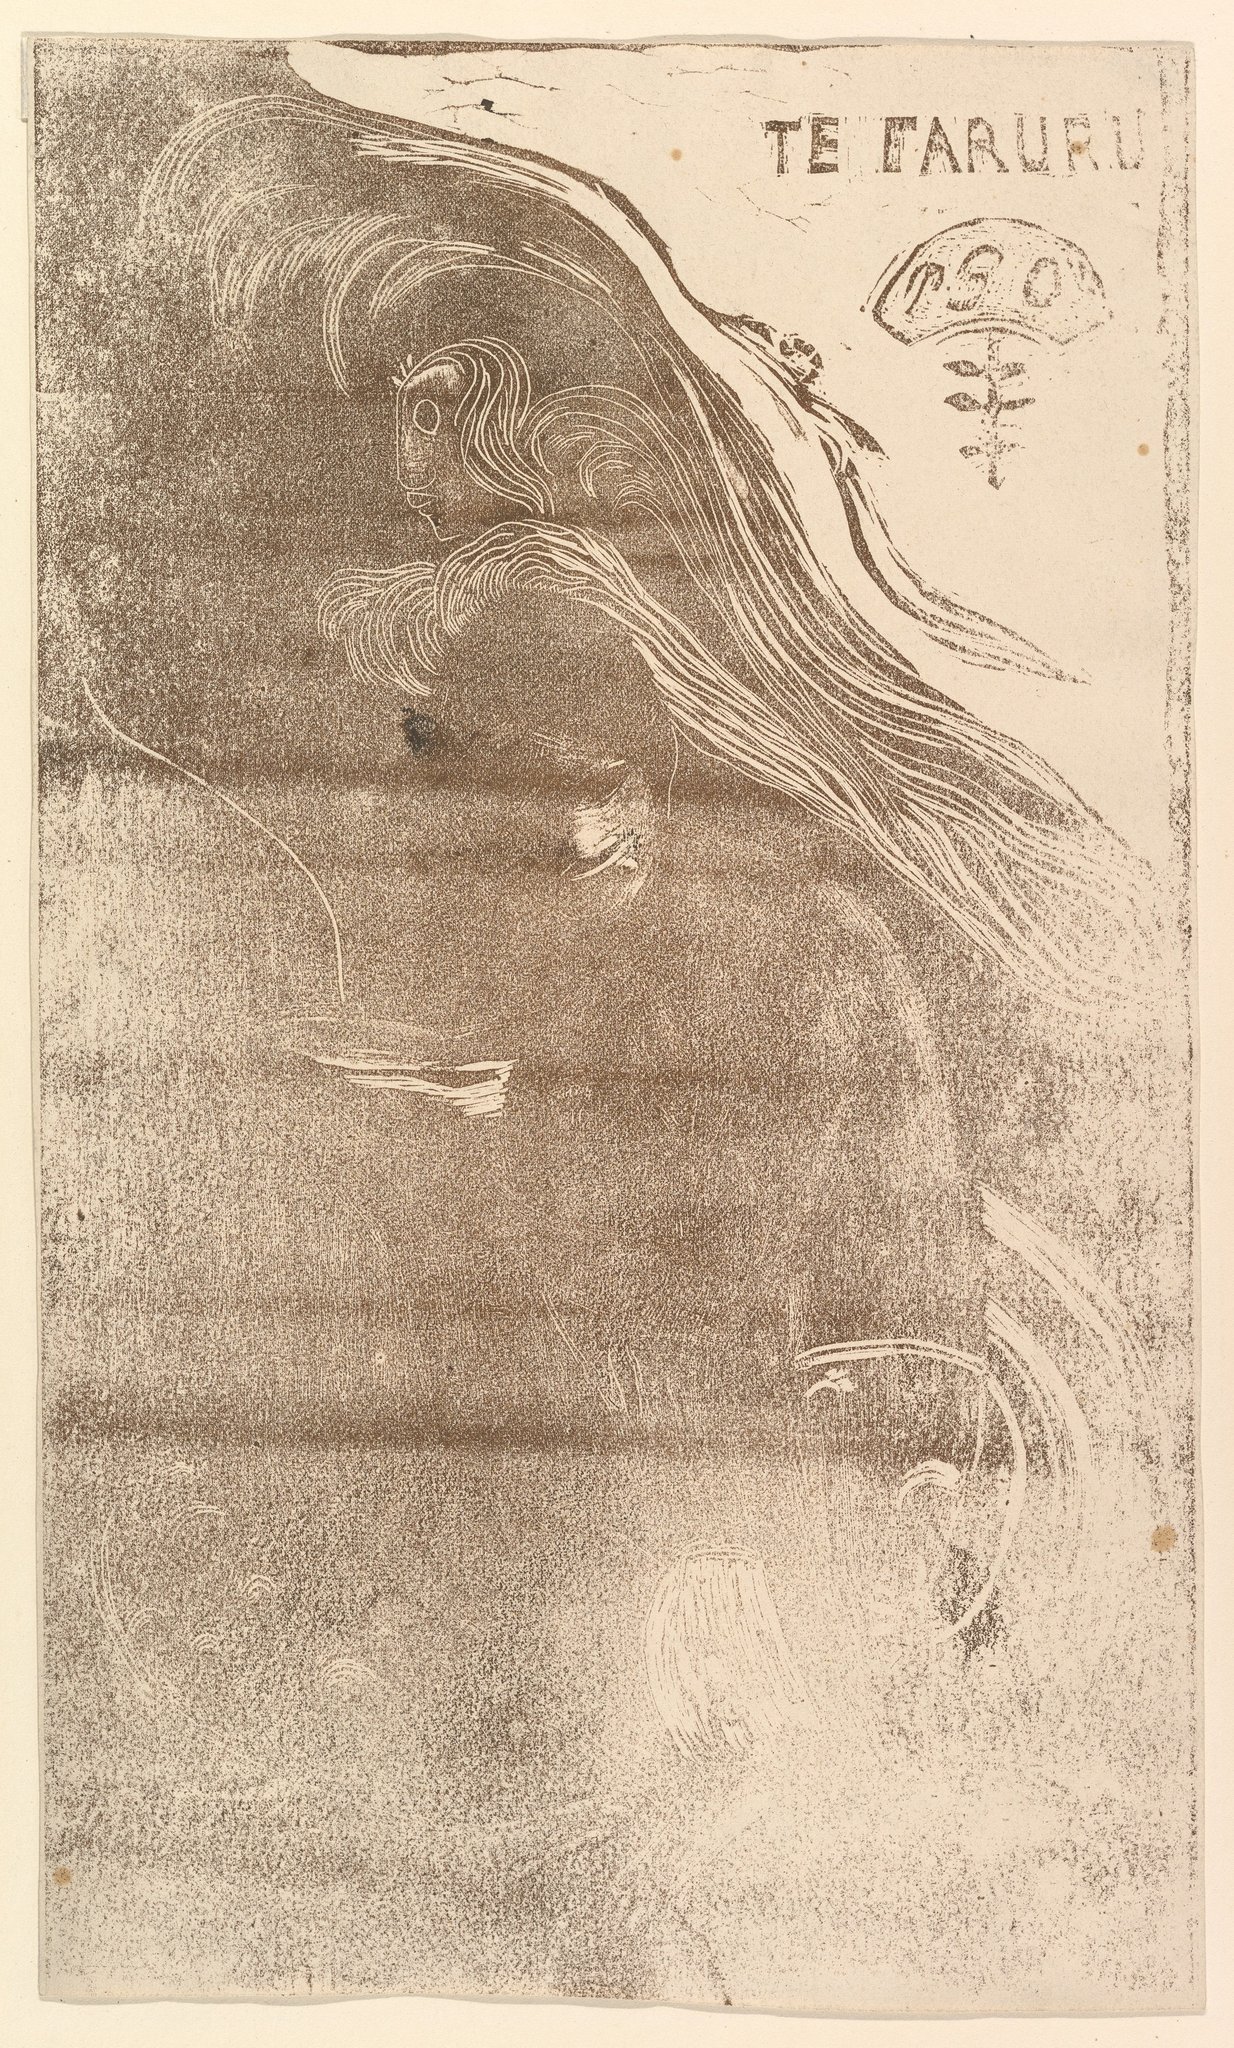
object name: print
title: Here we make love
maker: paul gauguin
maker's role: artist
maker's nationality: french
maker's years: 1848-1903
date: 1893-1894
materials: paper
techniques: printing, woodcut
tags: abstraction